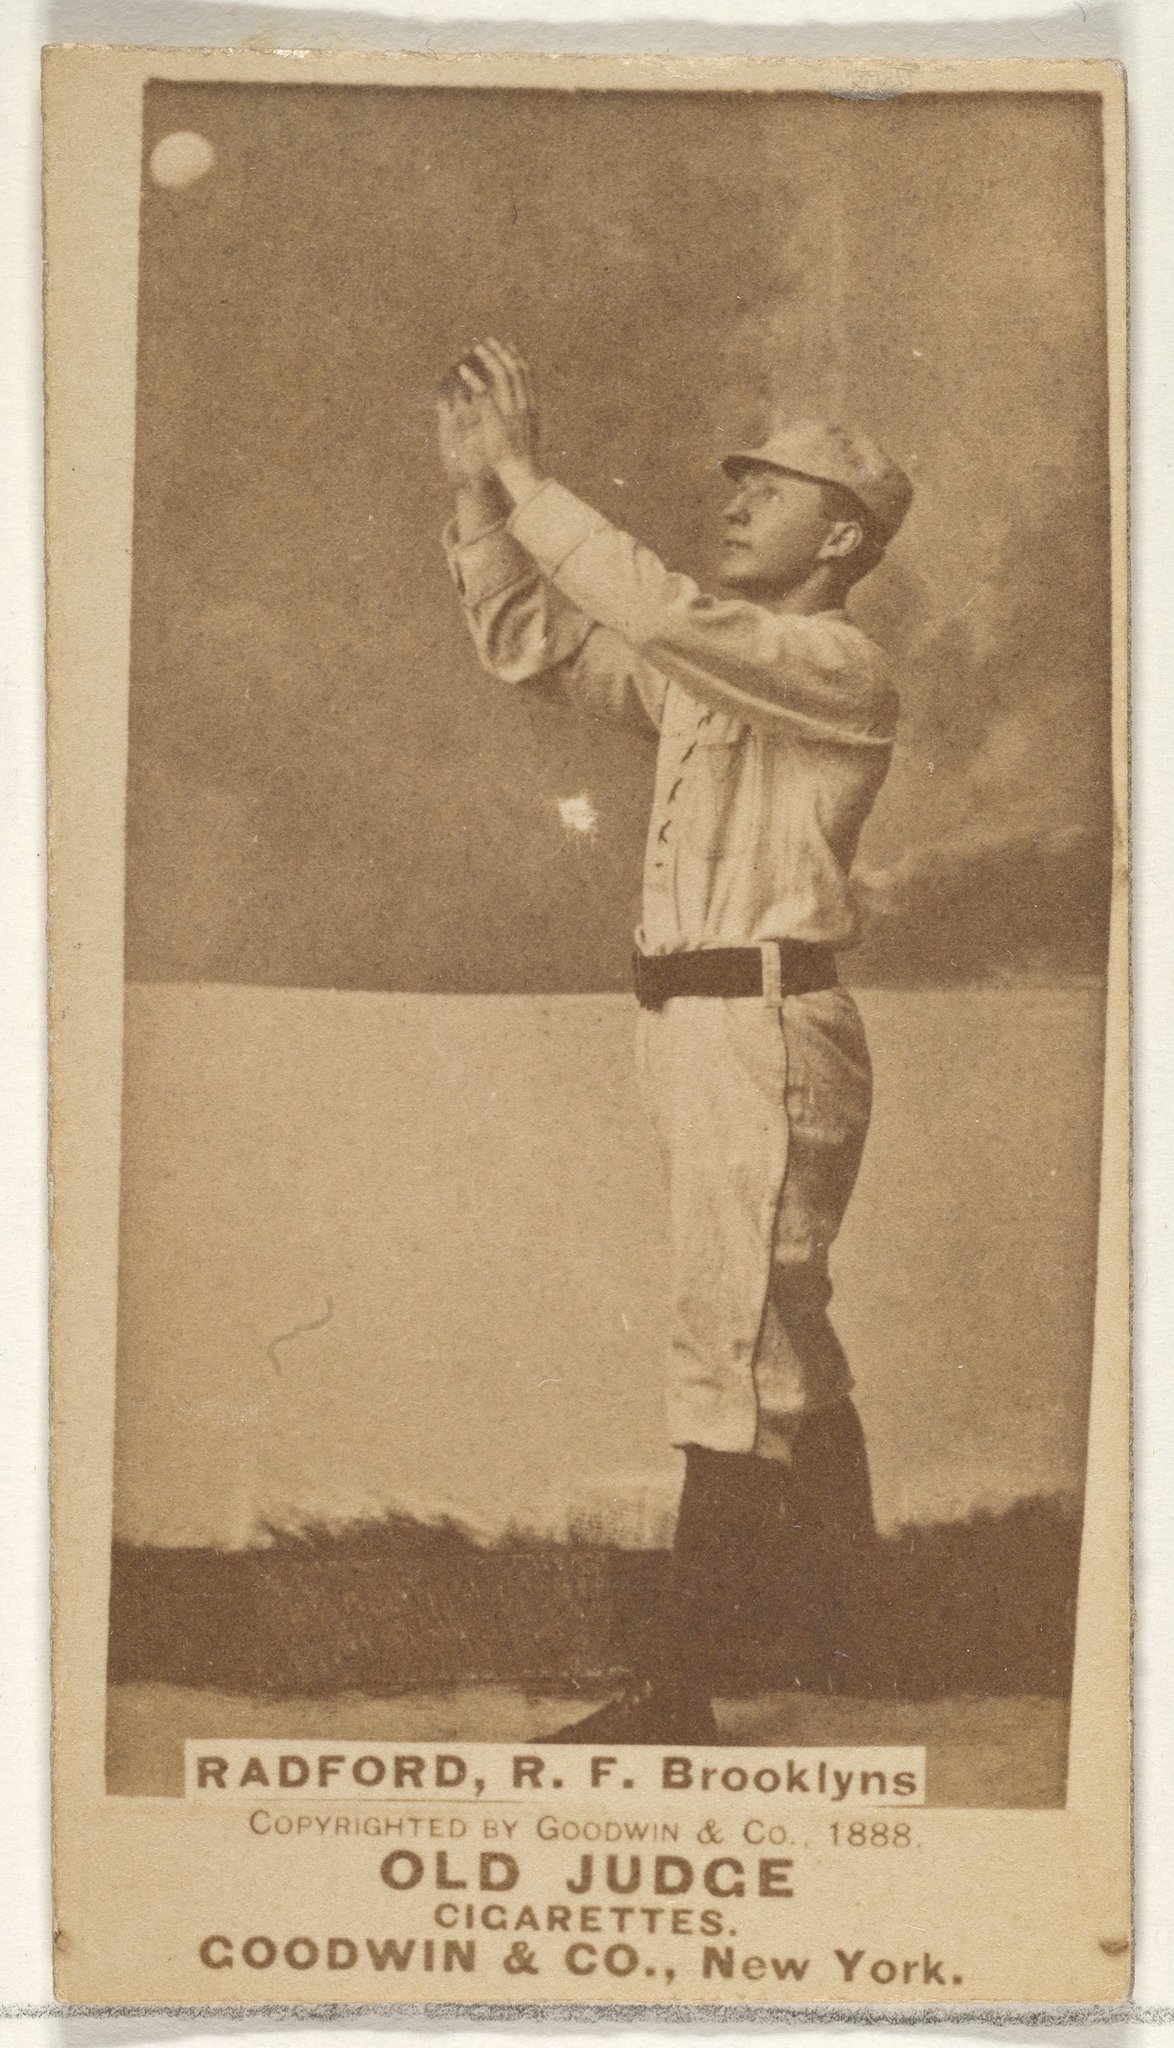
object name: baseball card, photograph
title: Radford, Right Field, Brooklyn Bridegrooms, from the Old Judge series (N172) for Old Judge Cigarettes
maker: goodwin & company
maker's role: publisher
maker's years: 1850-1950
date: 1888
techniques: albumen silver print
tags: men,portraits,baseball,athletes